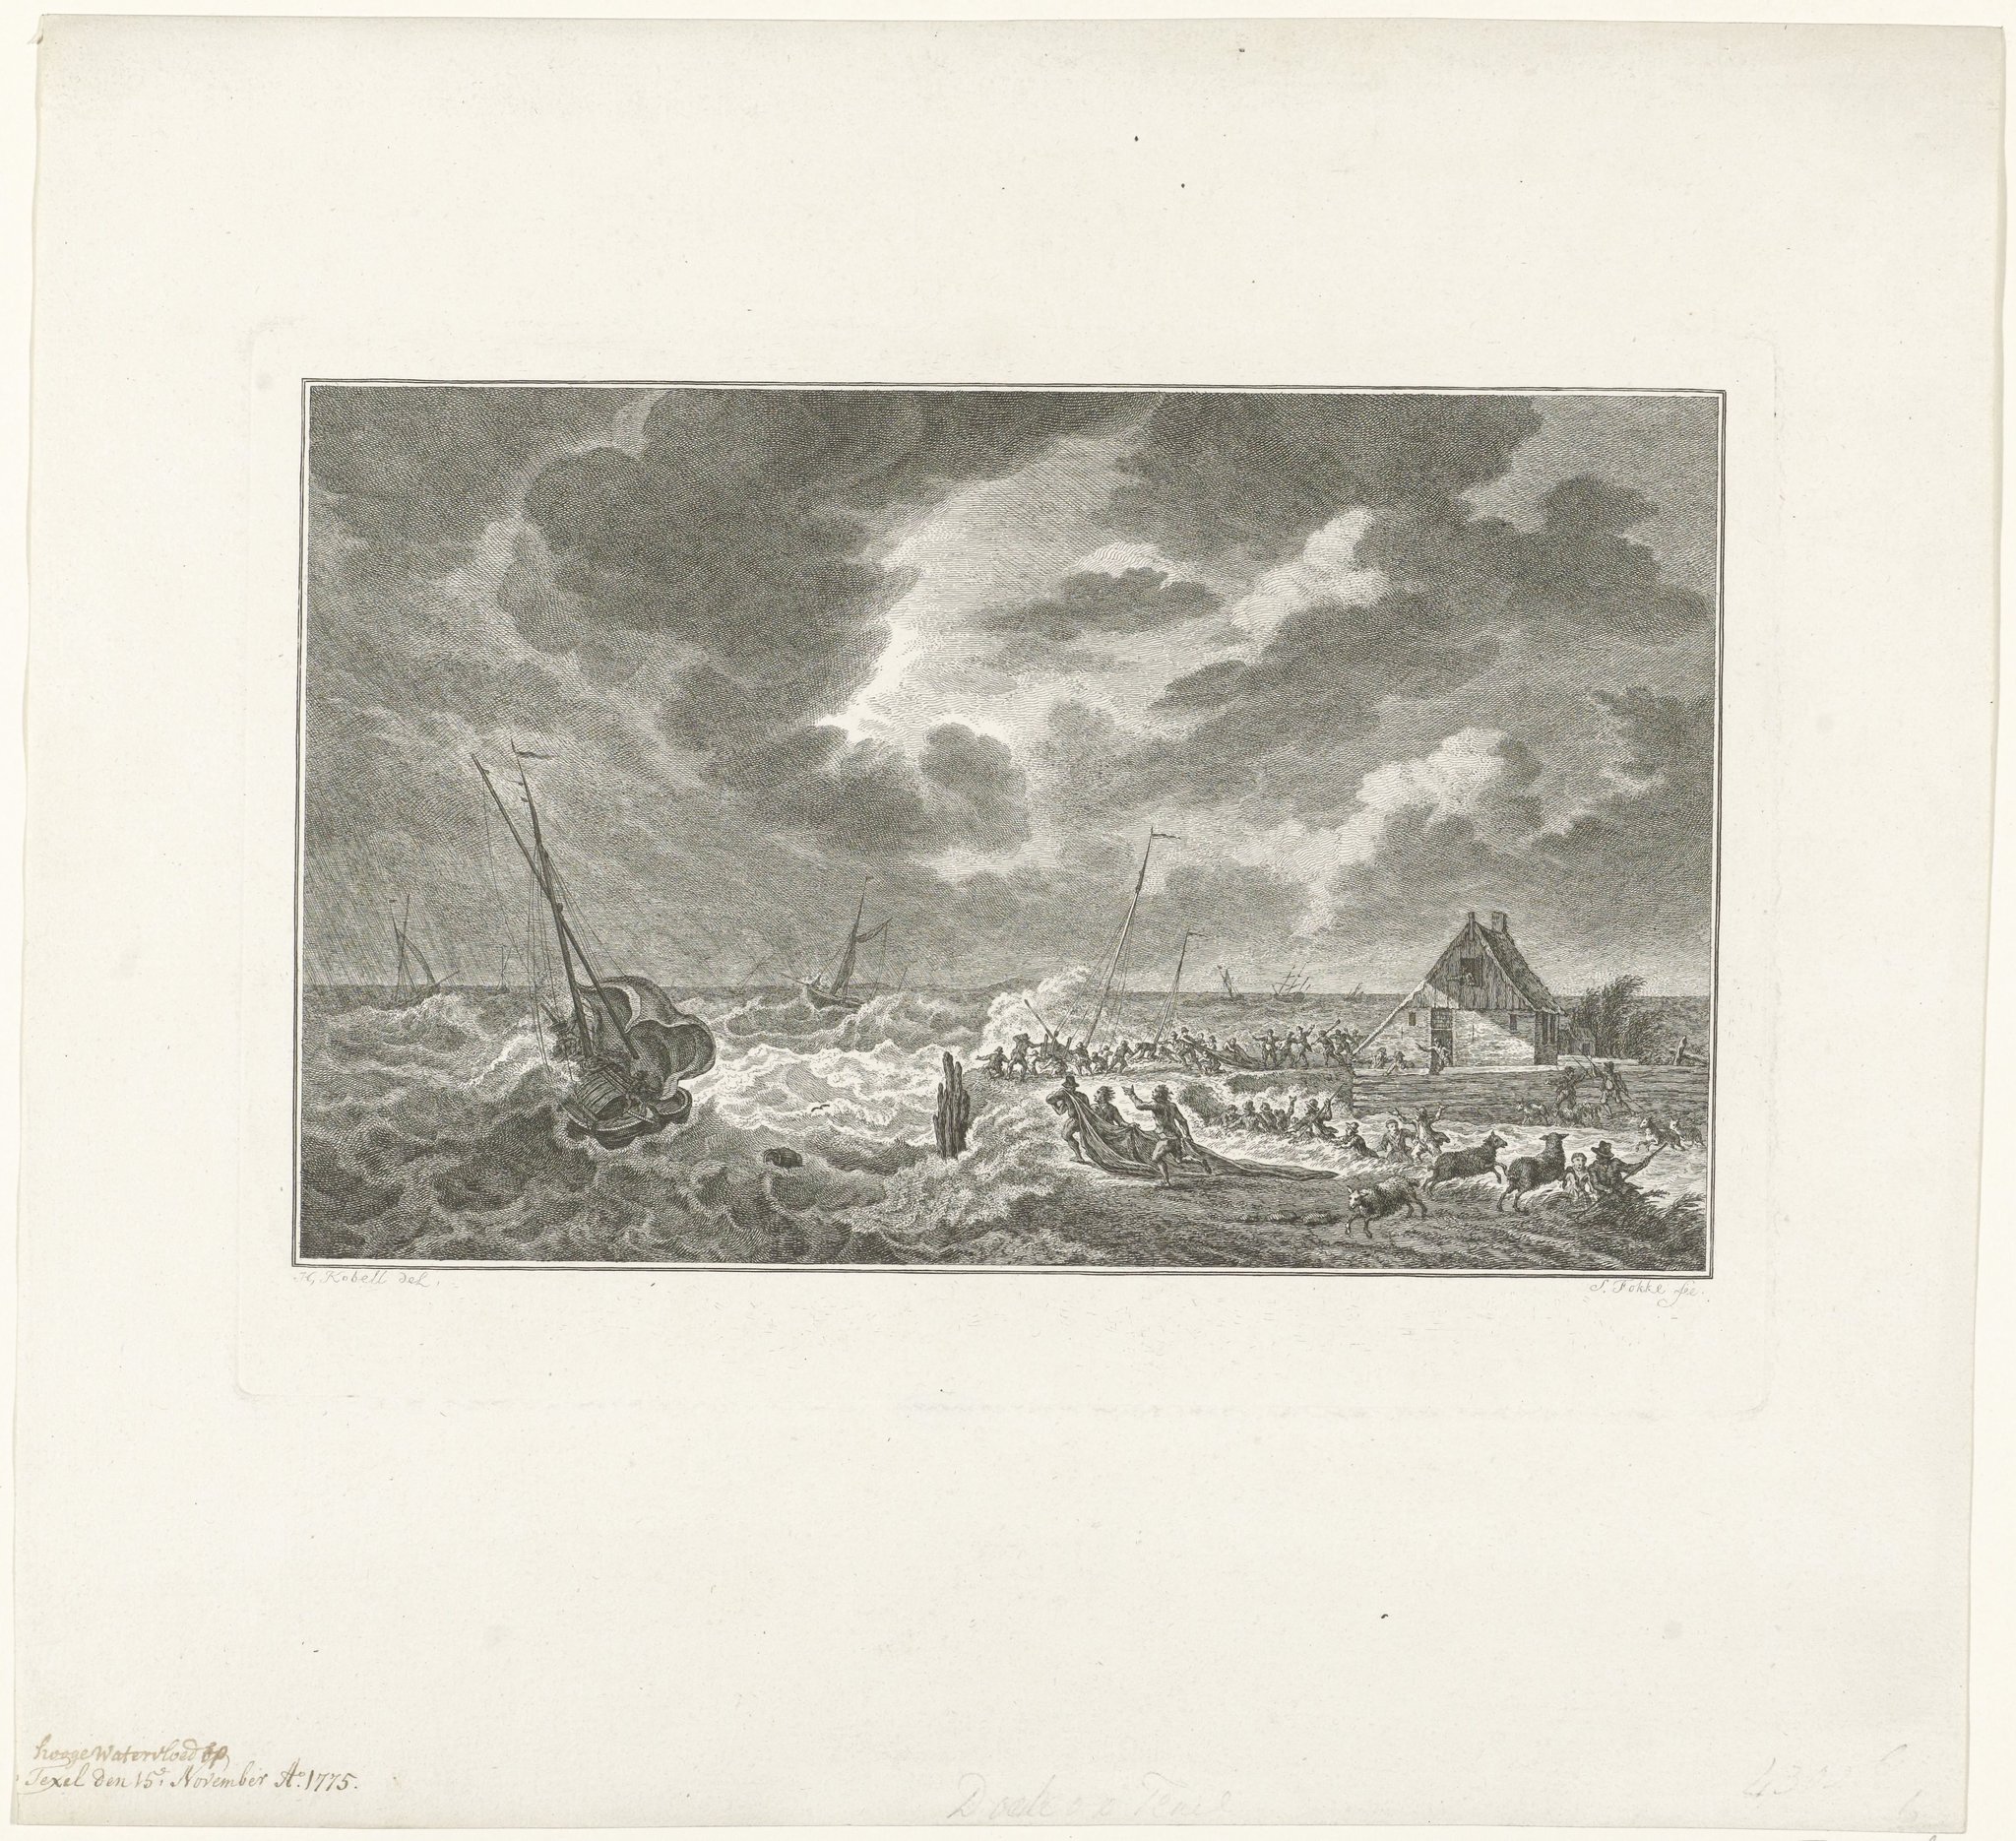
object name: print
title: Dijkdoorbraak op Texel, 1775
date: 1775-1776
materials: paper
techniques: engraving, etching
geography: northern netherlands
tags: dike-break, the flood of 14-18 november 1775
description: Gebruikt als illustratie in: J.H. Hering, Bespiegeling over Neêrlandsch waternood, tusschen den 14den. en 15den. nov: MDCCLXXV. 2 dln. Amsterdam: wed. Loveringh en Allart, 1776.